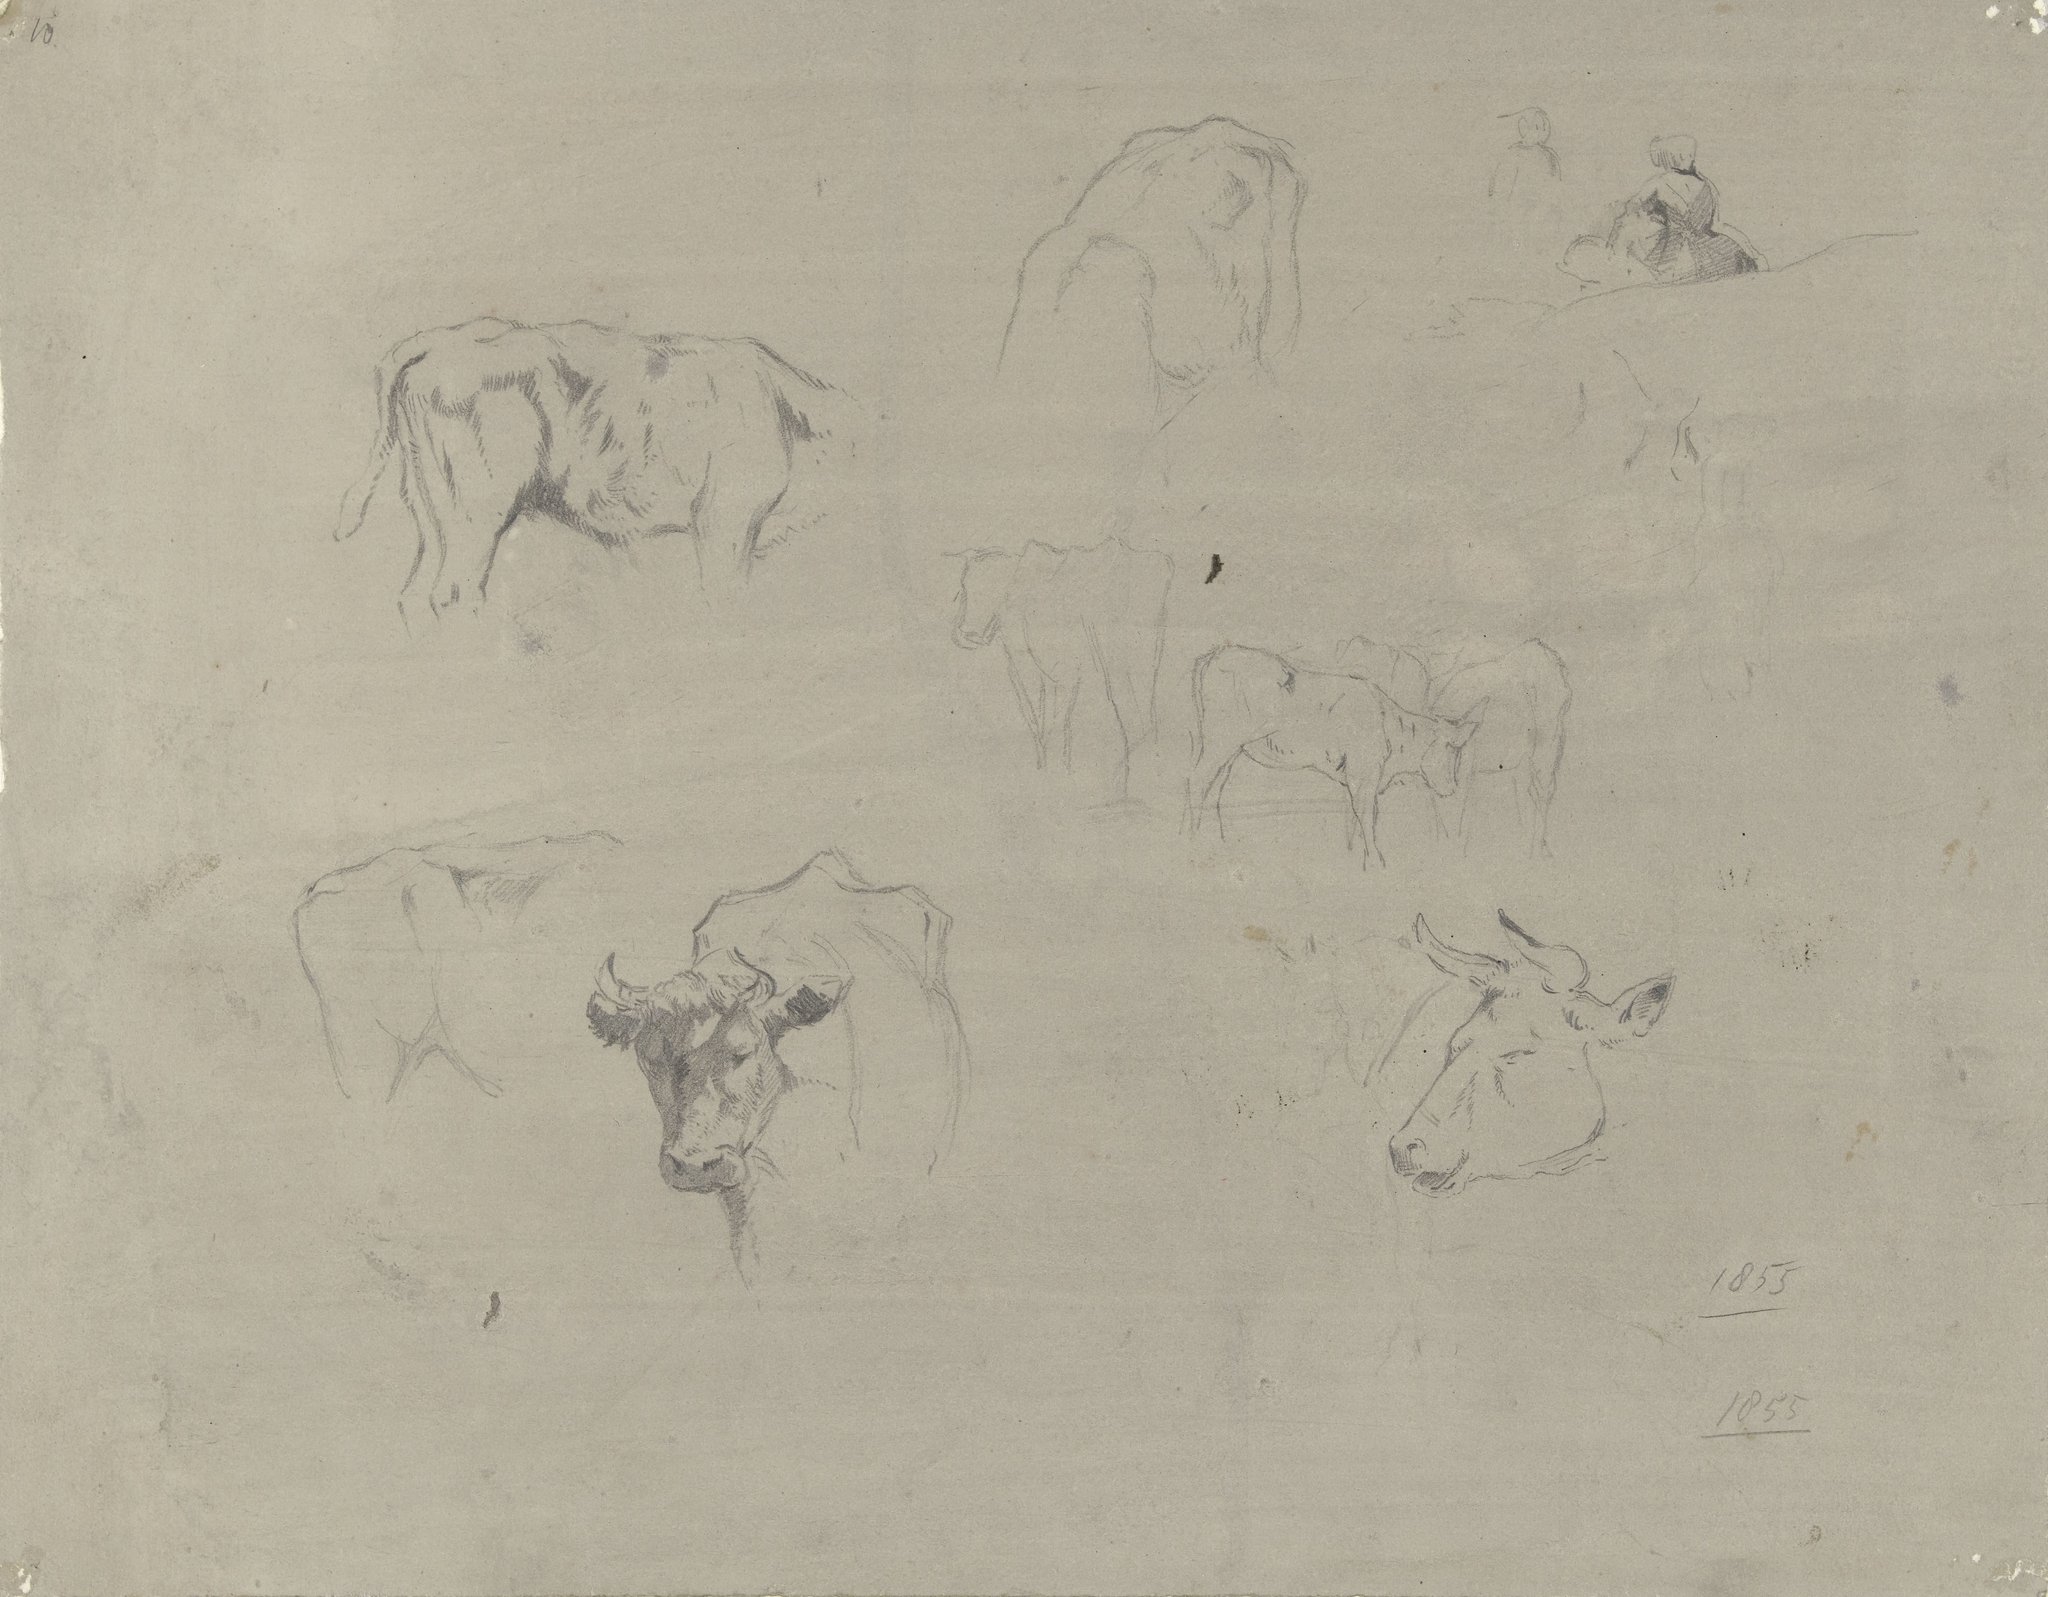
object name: drawing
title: Studies van koeien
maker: gerard bilders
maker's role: draughtsman, print maker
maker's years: 1838-1865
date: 1855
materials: pencil, paper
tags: cow